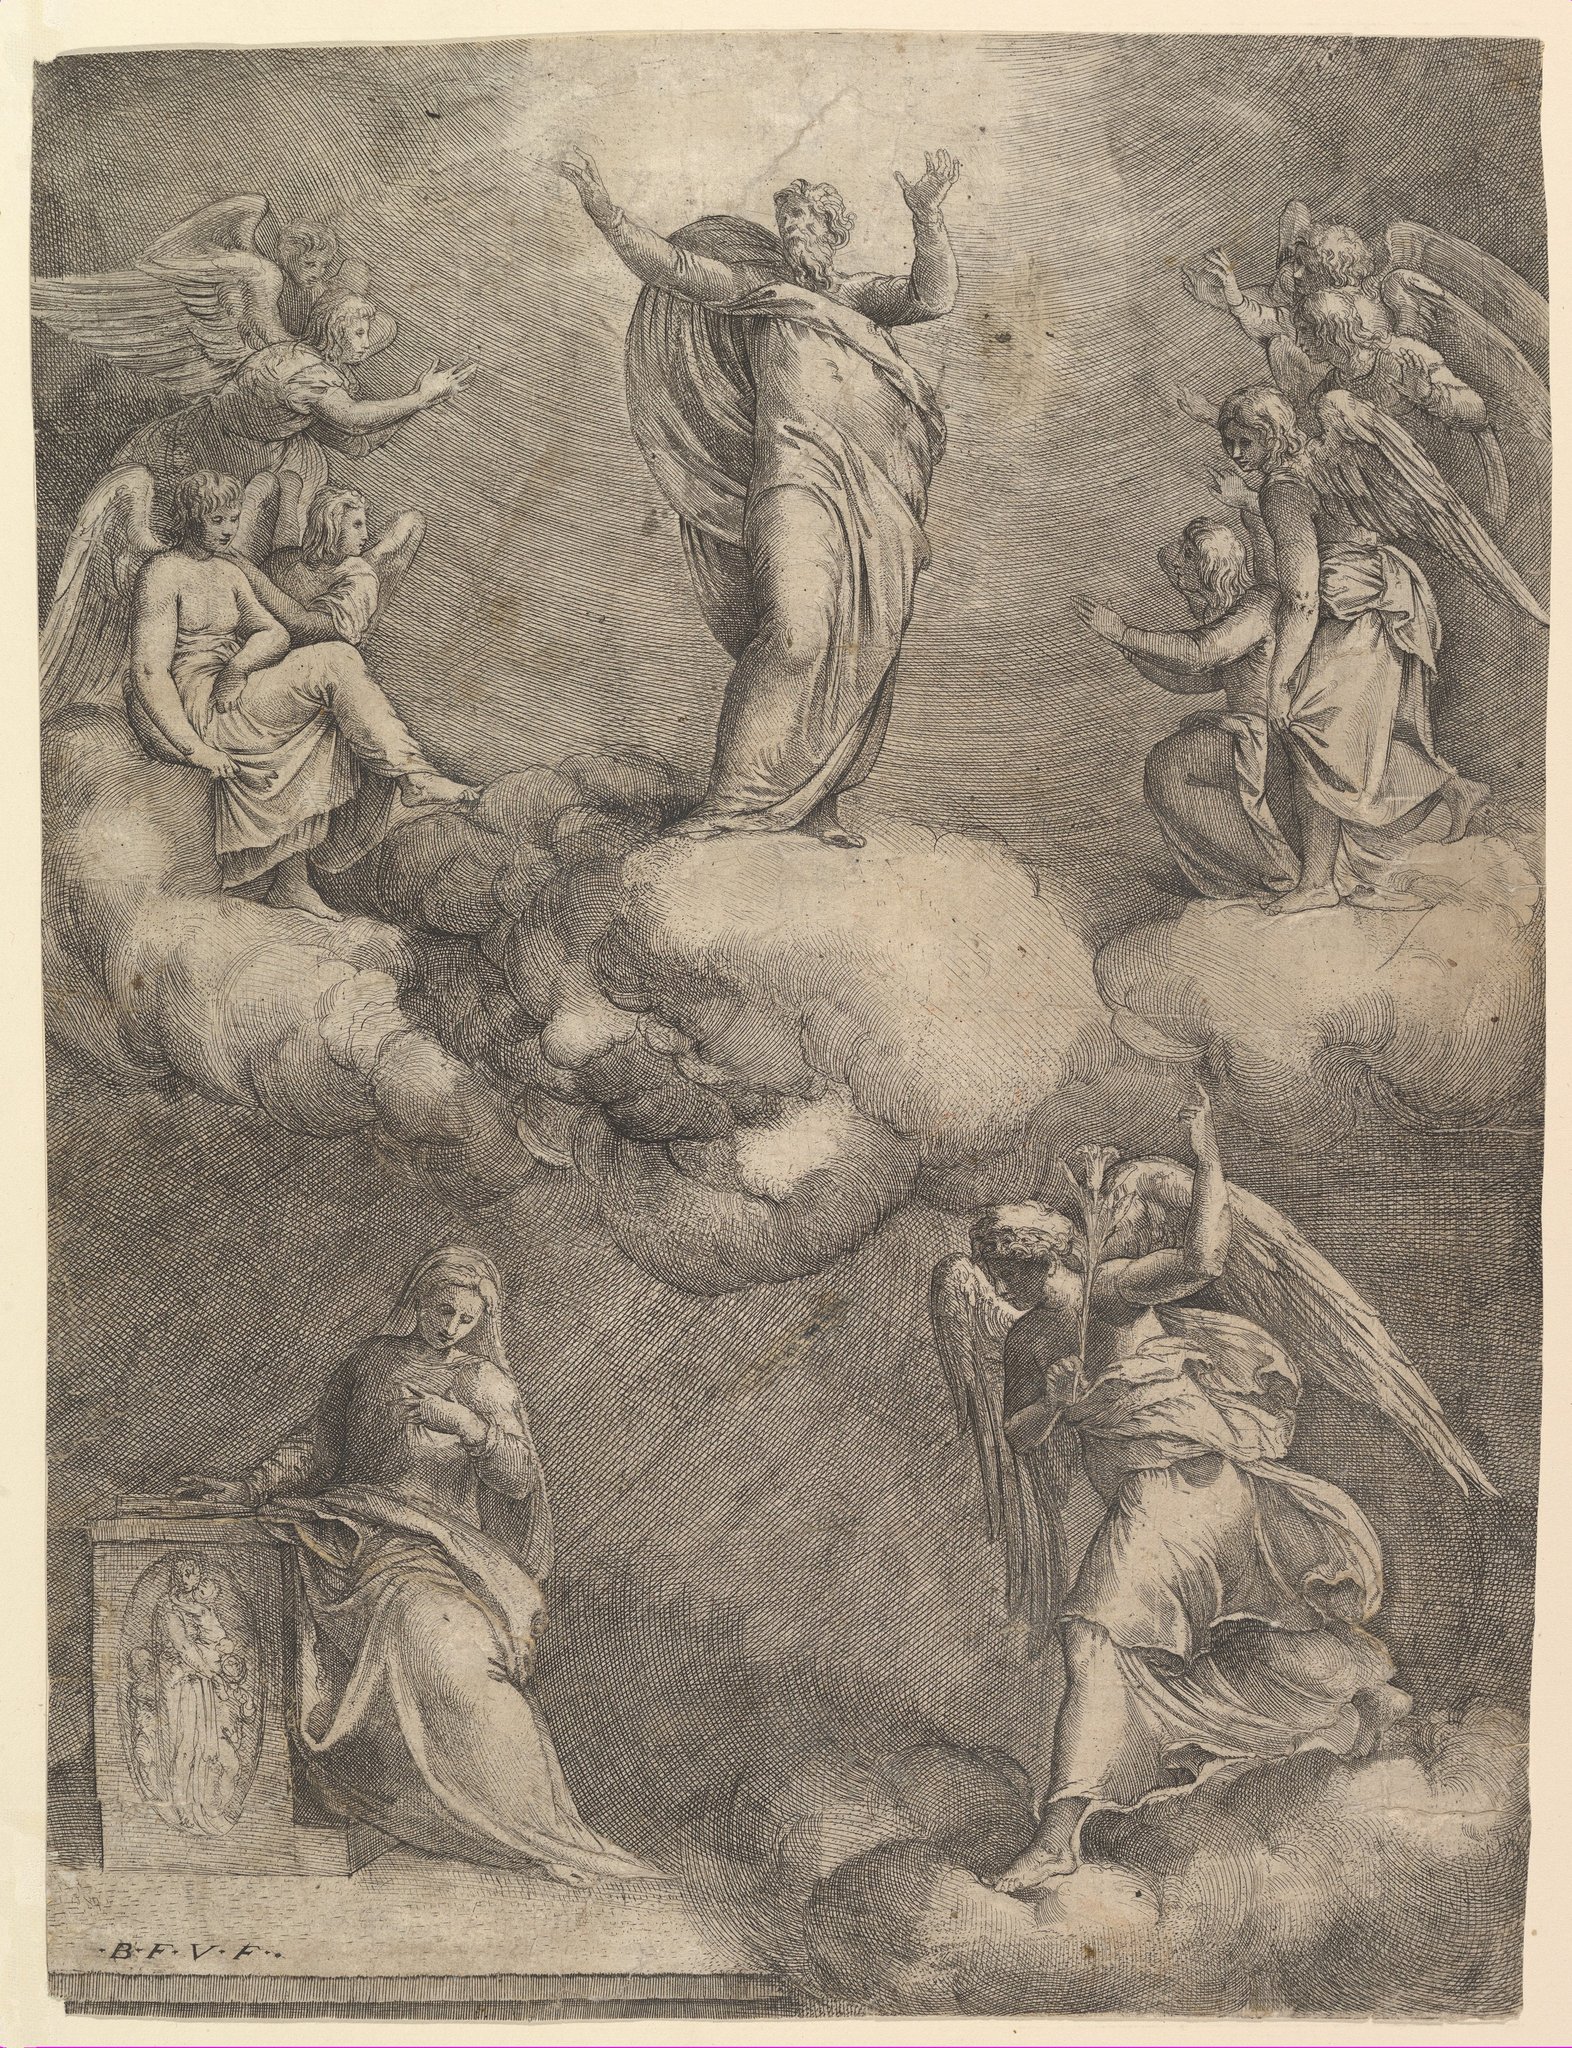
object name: print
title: The Annunciation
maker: battista franco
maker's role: artist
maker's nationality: italian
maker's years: 1510-1561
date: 1557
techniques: engraving, etching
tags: angels,annunciation